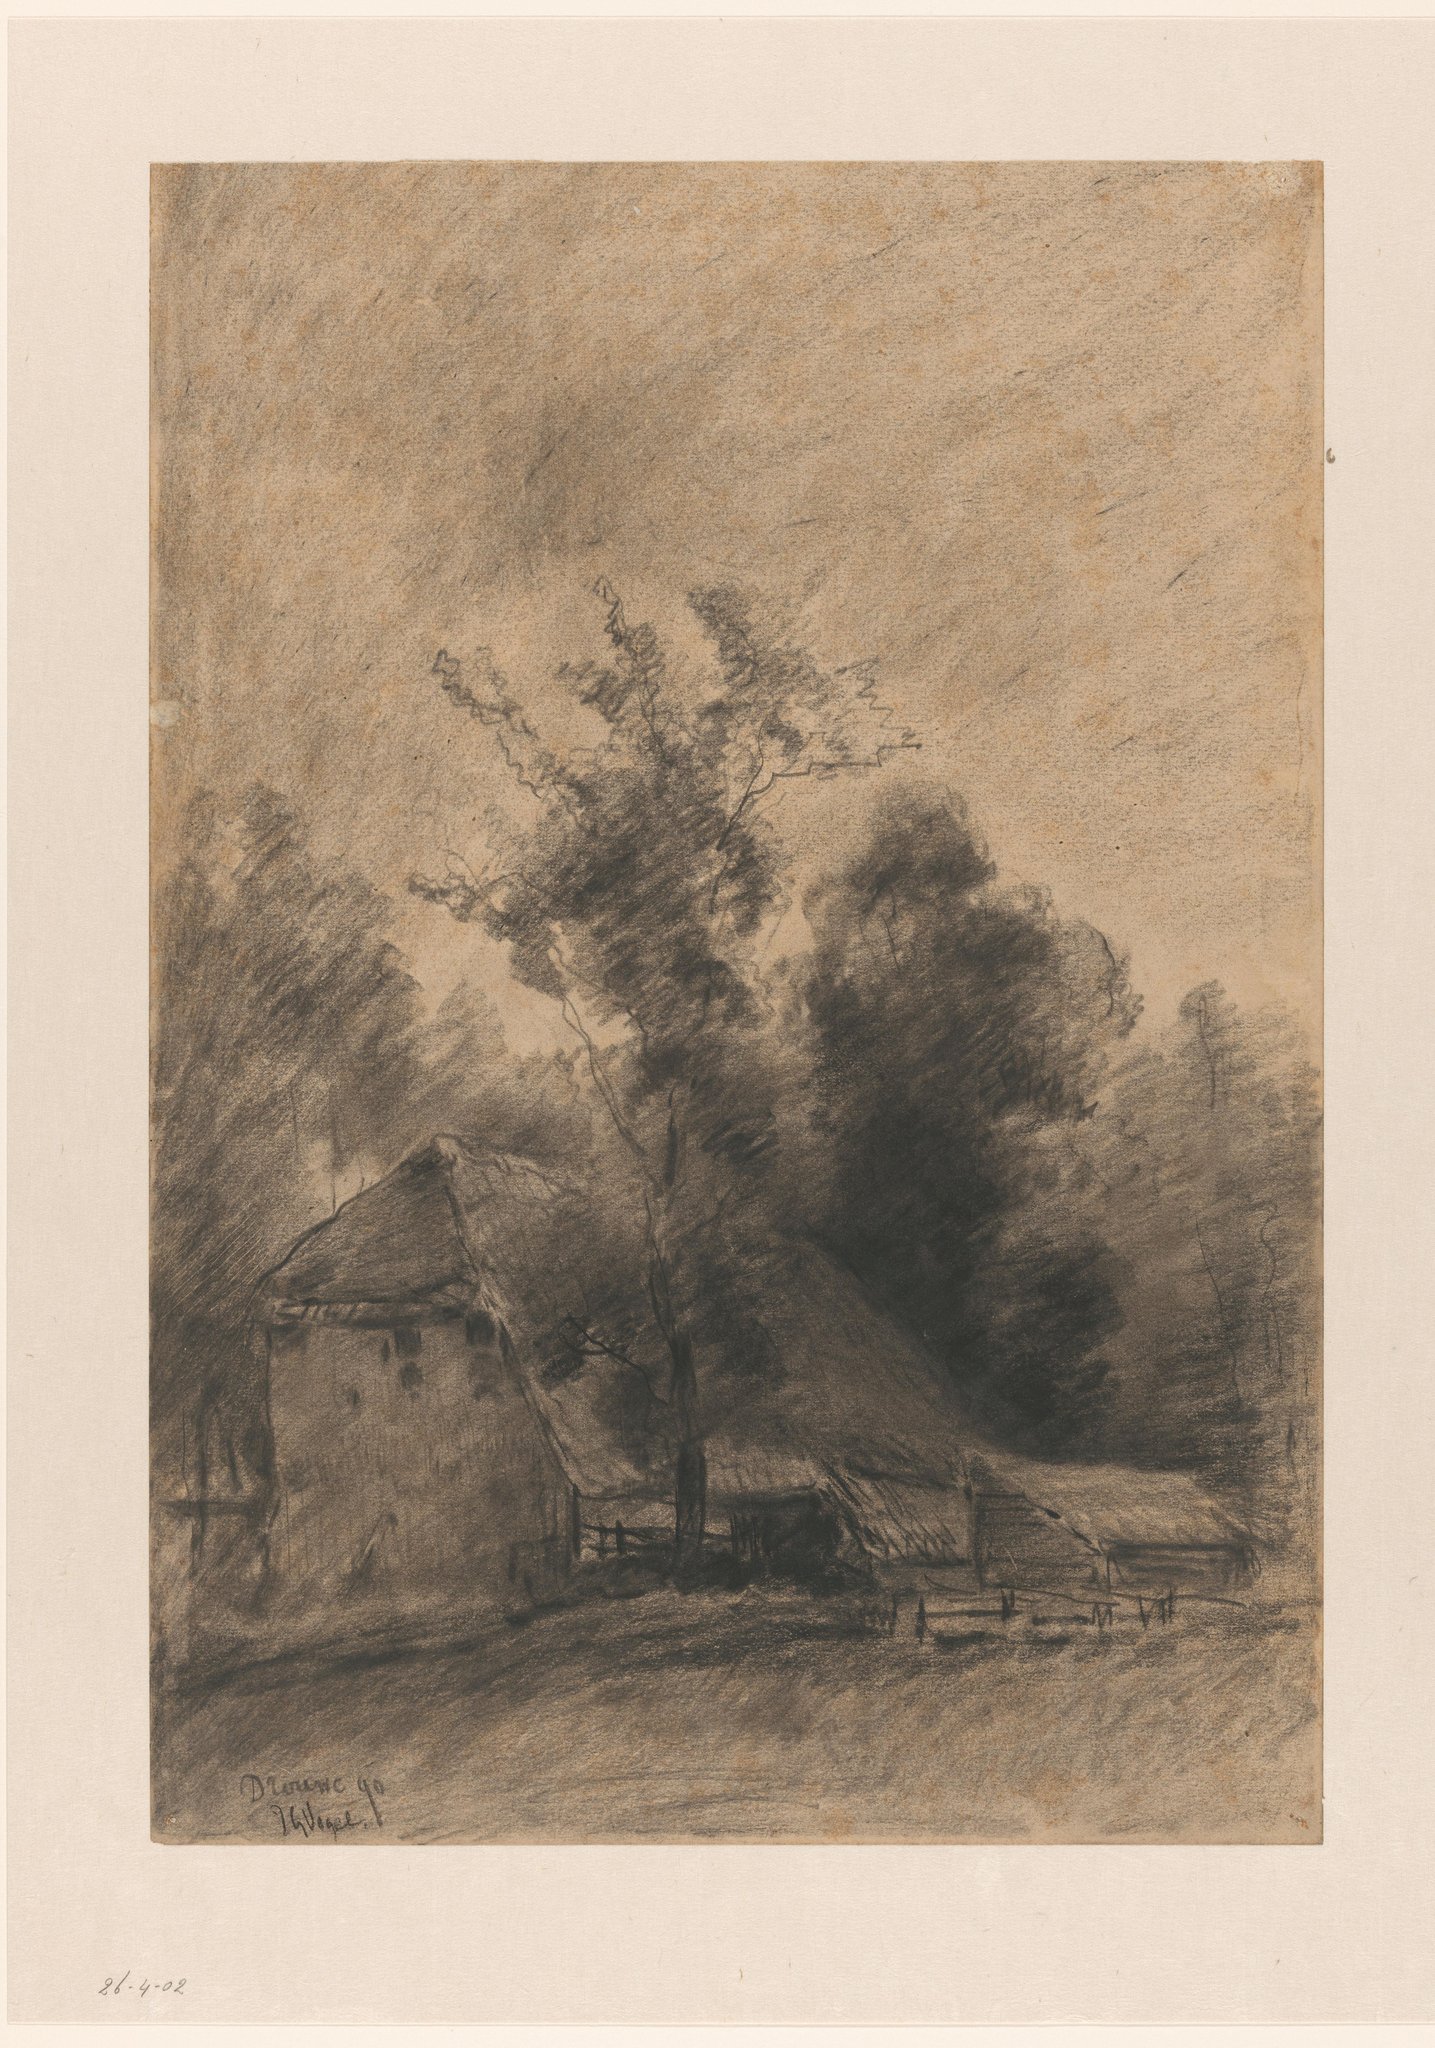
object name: drawing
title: Boerderij tussen bomen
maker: johannes gijsbert vogel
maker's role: draughtsman, painter, print maker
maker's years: 1828-1915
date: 1890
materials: chalk, paper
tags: farm (building)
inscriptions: date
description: Boerderij tussen bomen. Opschrift linksonder: Drouwe 90 / JGVogel.